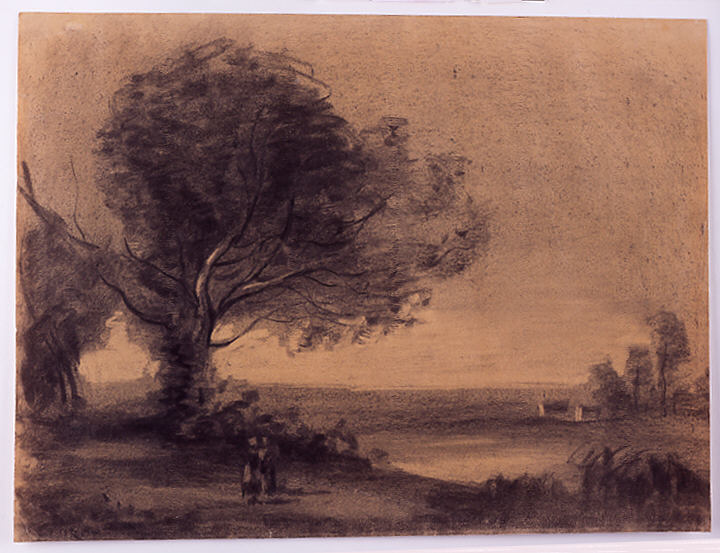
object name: drawing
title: Landscape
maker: jean-baptiste-camille corot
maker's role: artist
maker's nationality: french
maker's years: 1796-1875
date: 1855-1875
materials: charcoal, paper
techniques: highlighting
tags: landscapes,trees